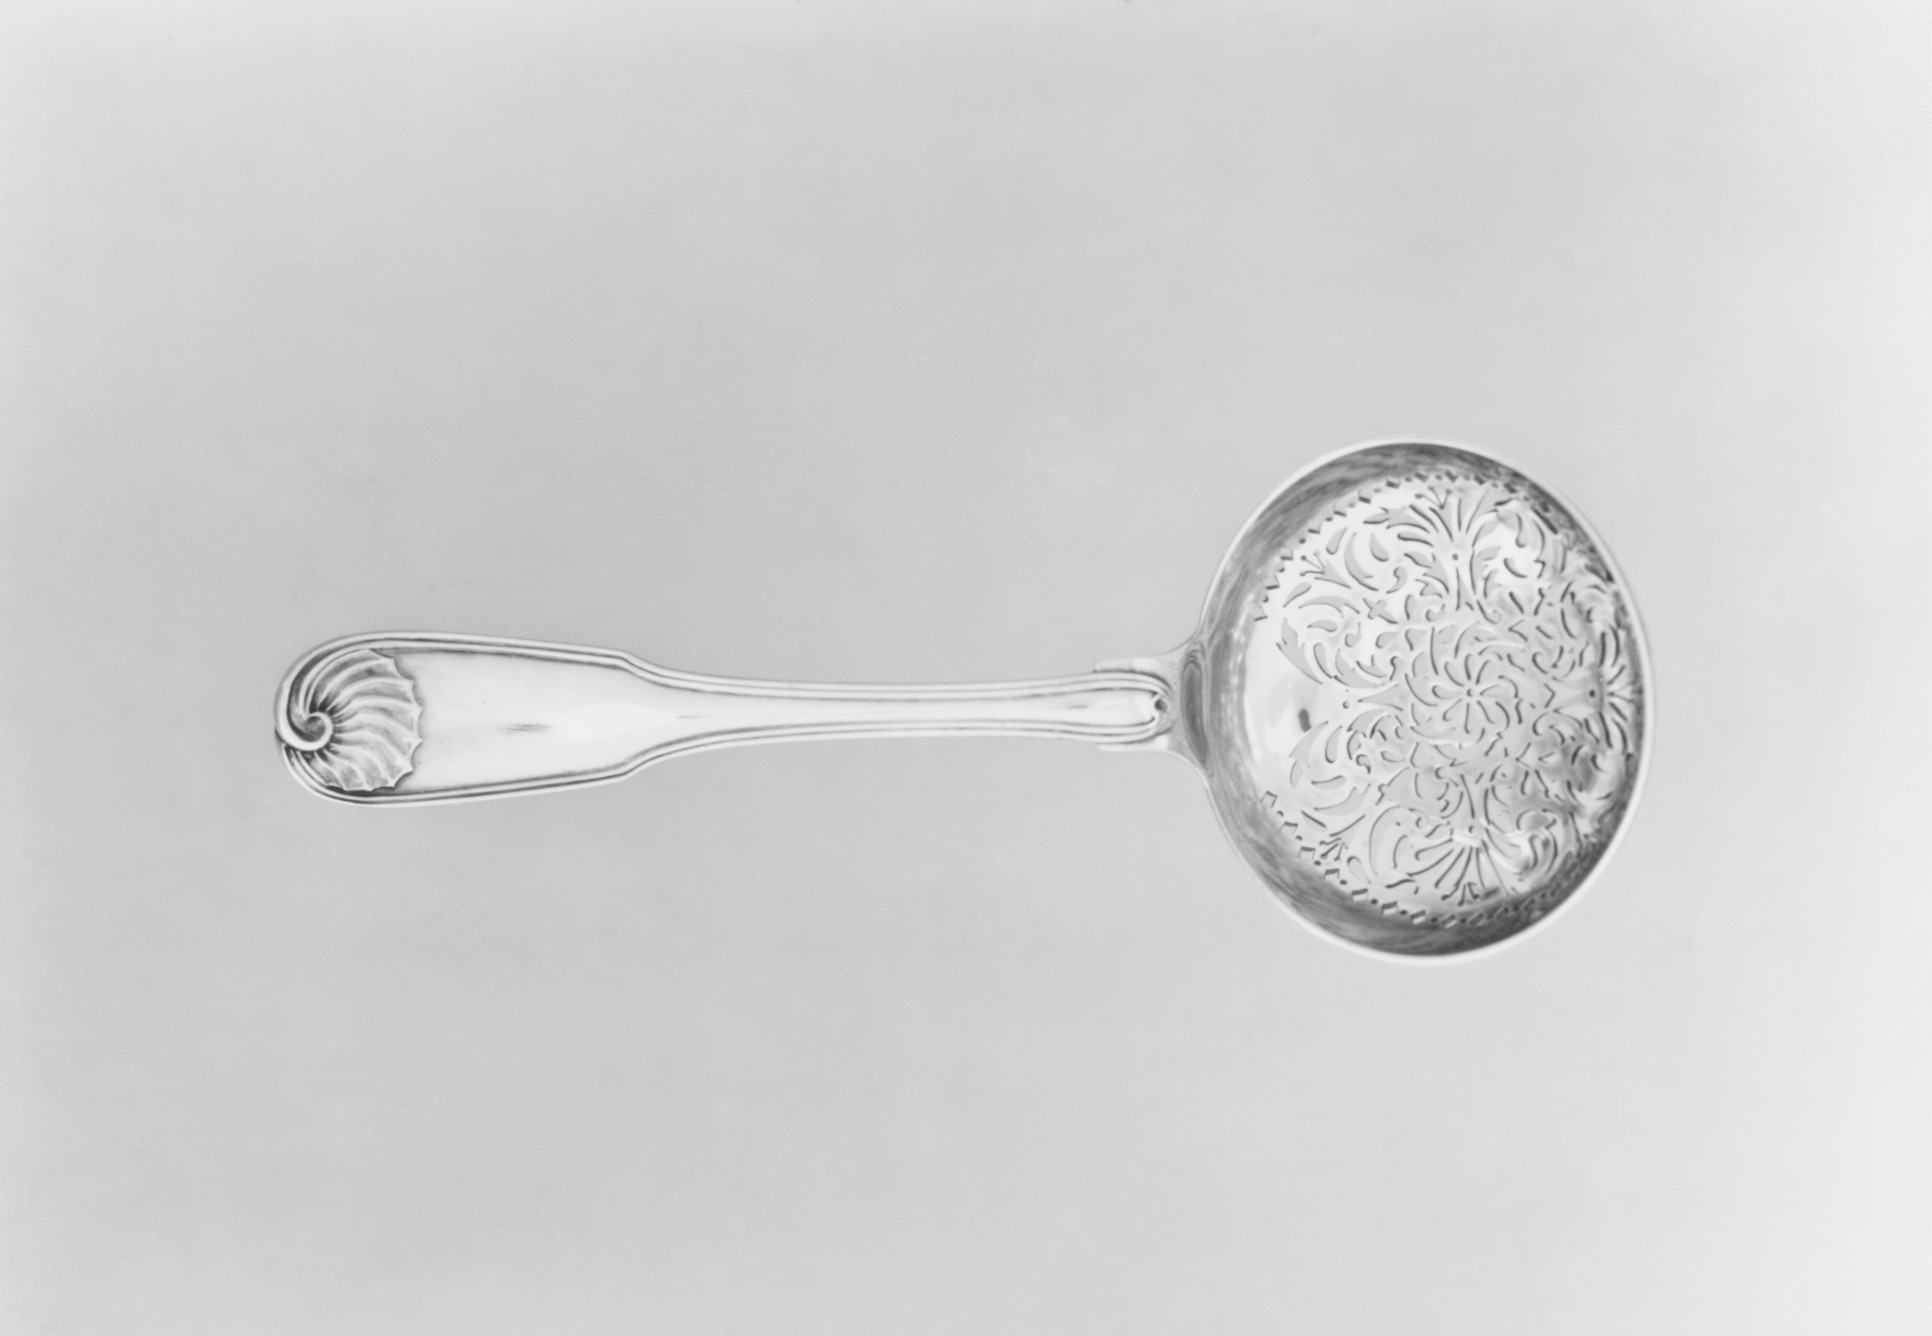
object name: sugar spoon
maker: jean chaslon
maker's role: maker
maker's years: 1733-1792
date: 1766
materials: silver